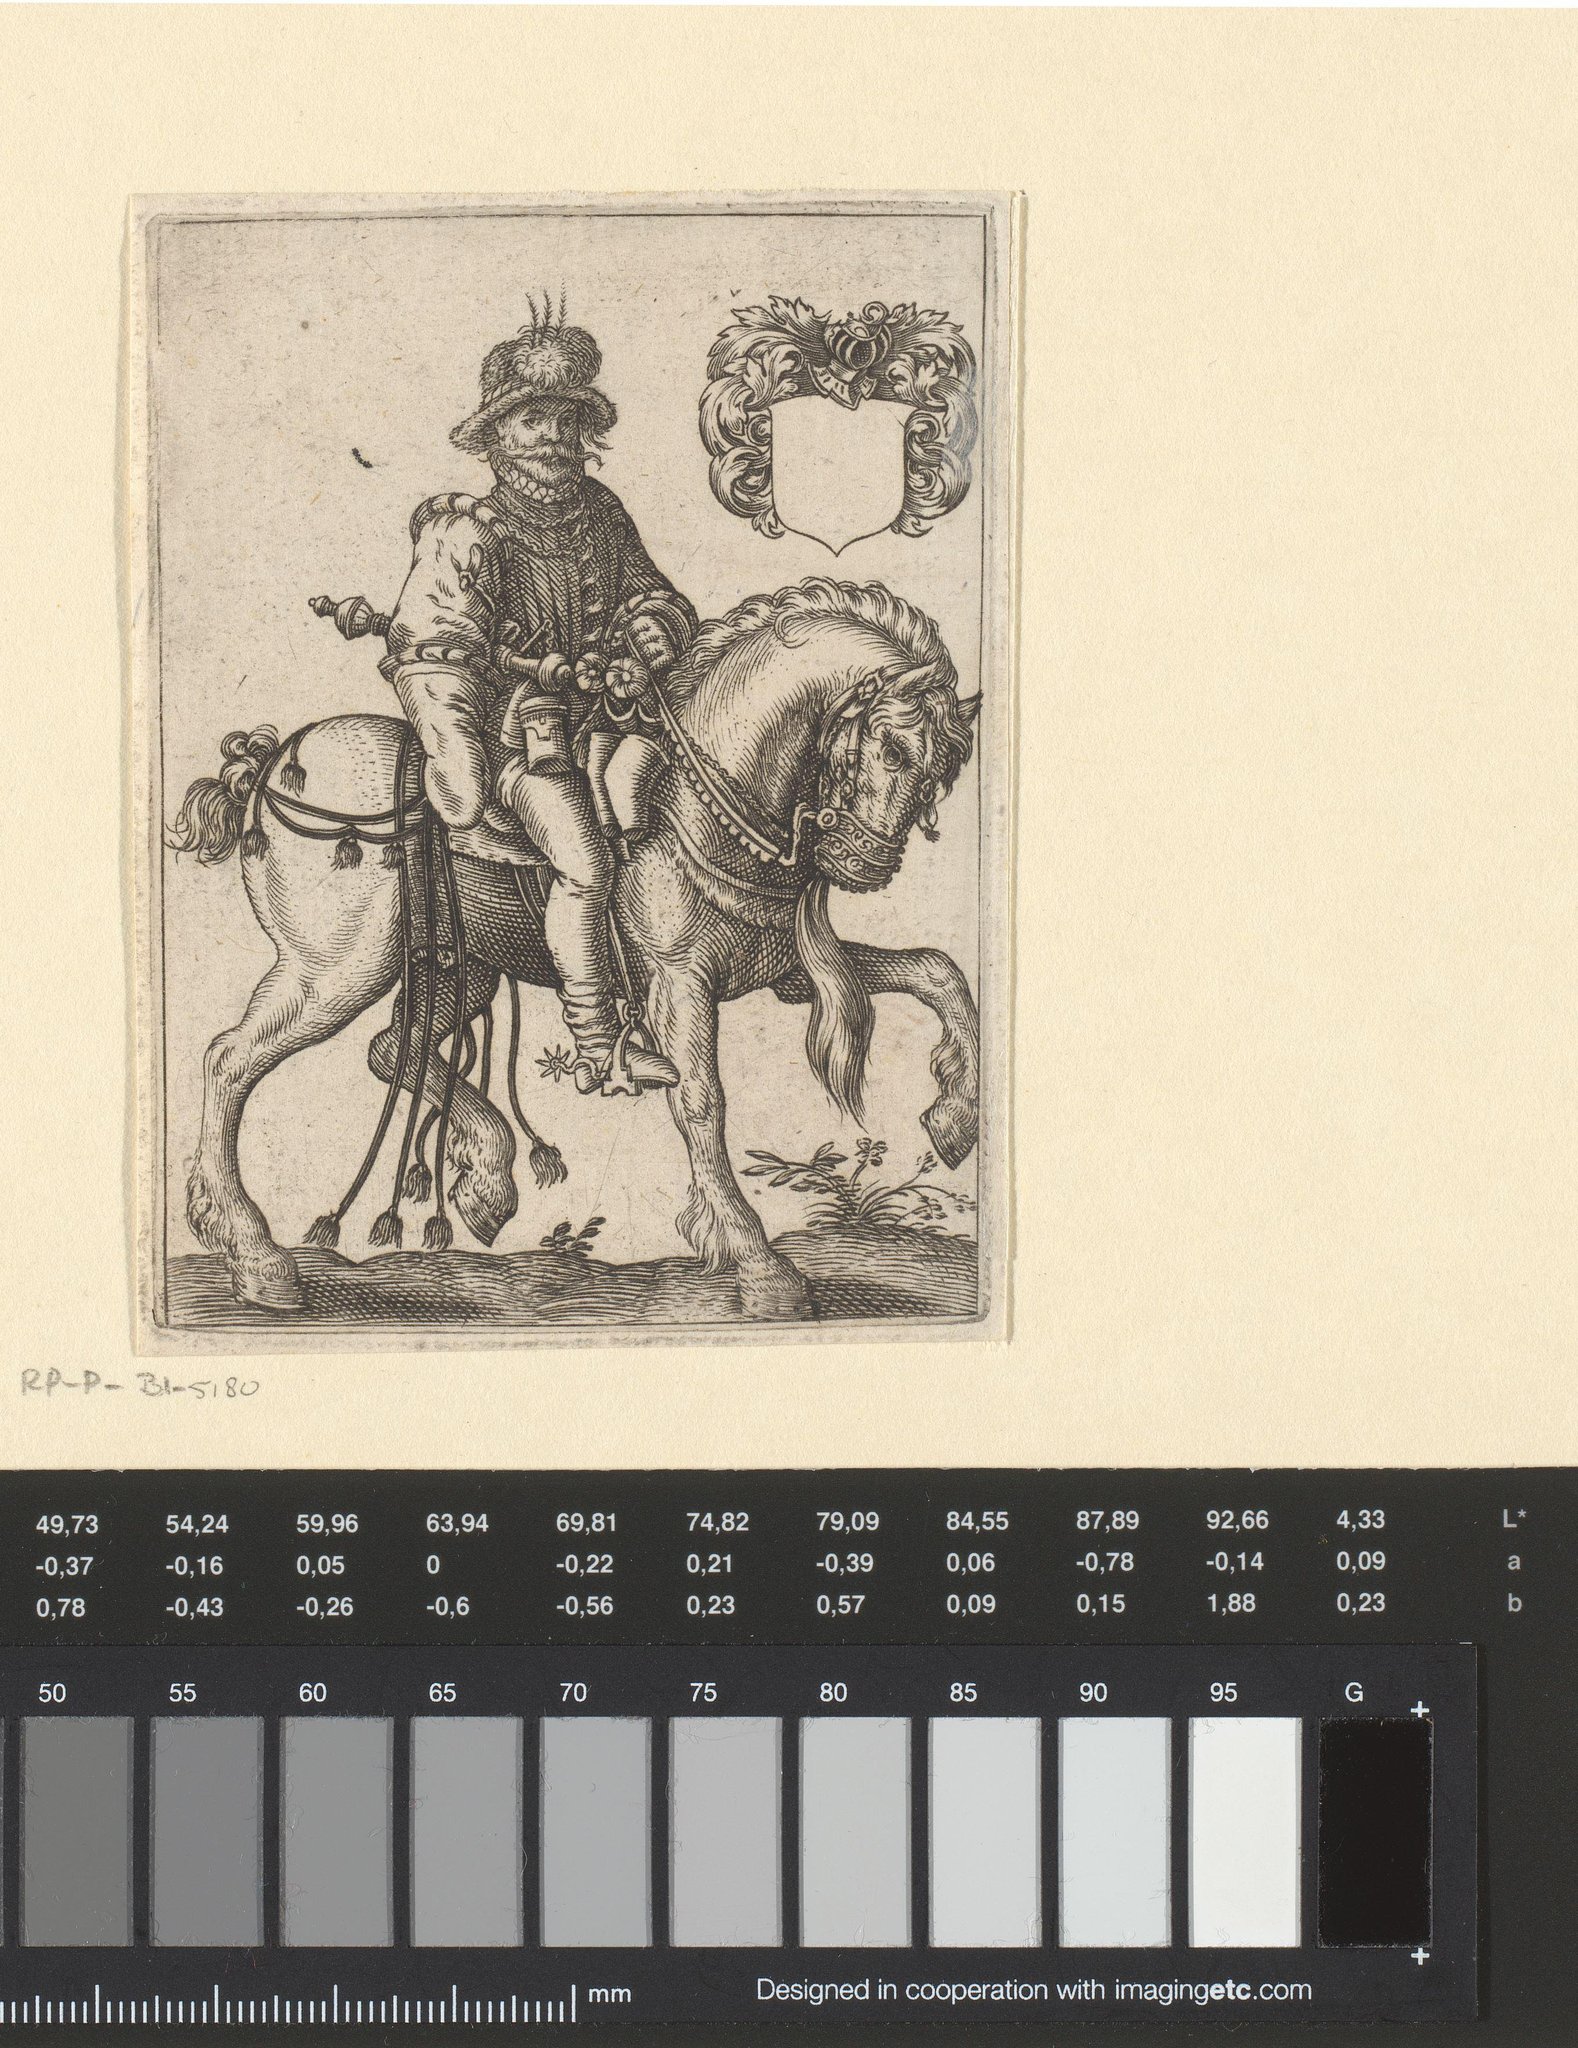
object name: print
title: Wapensjabloon met ruiter en paard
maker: johann theodor de bry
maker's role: print maker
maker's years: 1561-1623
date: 1596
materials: paper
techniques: engraving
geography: frankfurt am main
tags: riding a horse, ass, or mule; rider, horseman, armorial bearing, heraldry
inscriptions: collector's mark: Lugt 240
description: Afkomstig uit: Emblemata Saecularia. Mira et iucunda varietate seculi huius mores ita experimentia (...). 1e druk. Frankfurt am Main: J.T. de Bry en J.I. de Bry, 1596.